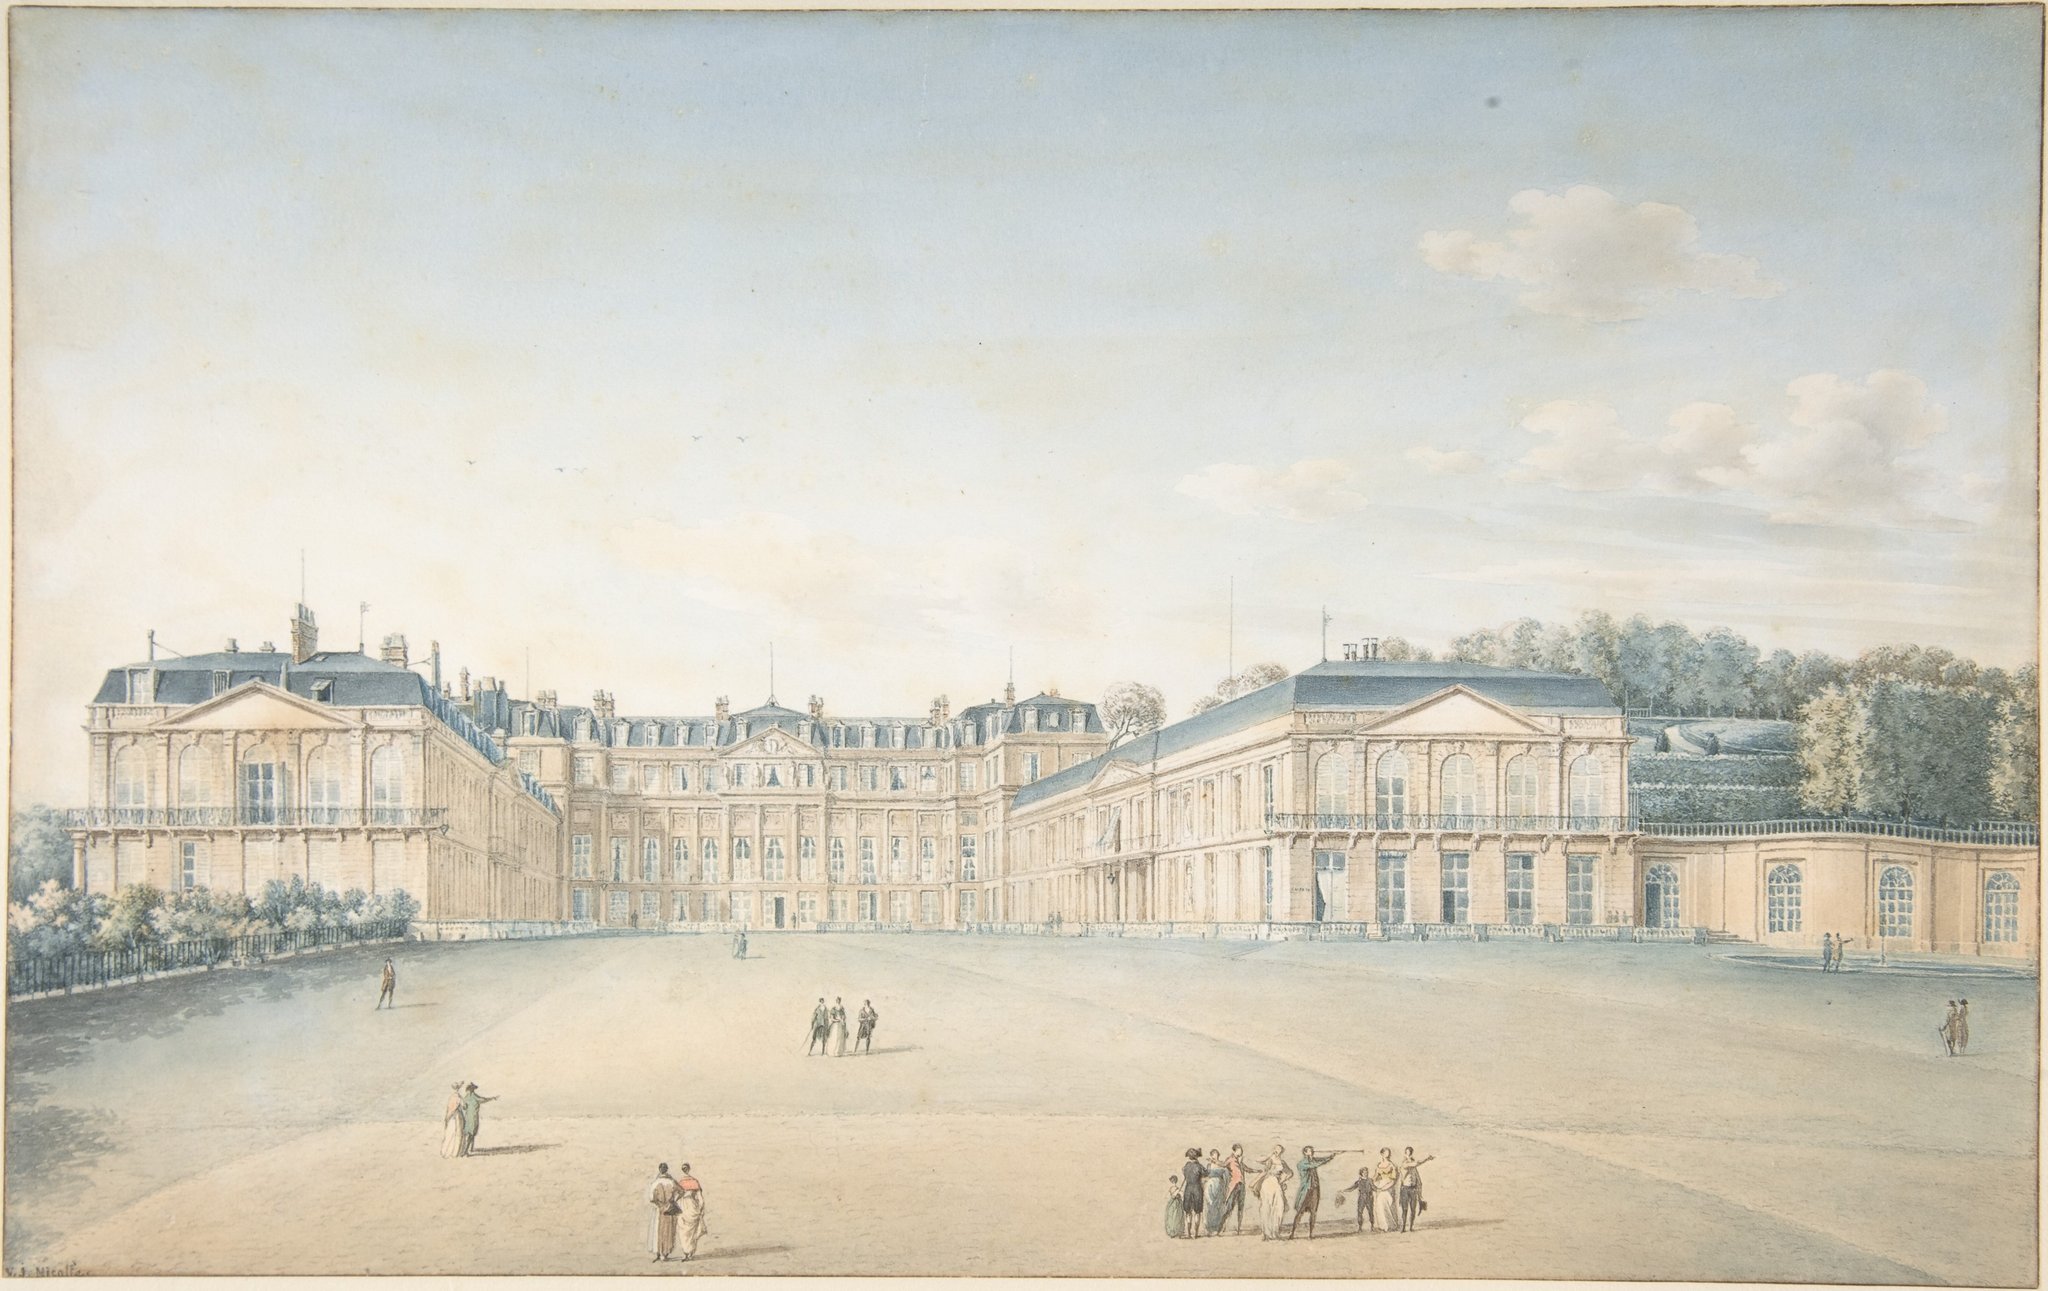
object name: drawing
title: Courtyard of the Chateau de Saint-Cloud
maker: victor jean nicolle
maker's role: artist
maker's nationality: french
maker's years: 1754-1826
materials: graphite, ink, watercolor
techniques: pen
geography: france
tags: architecture,buildings,courtyards